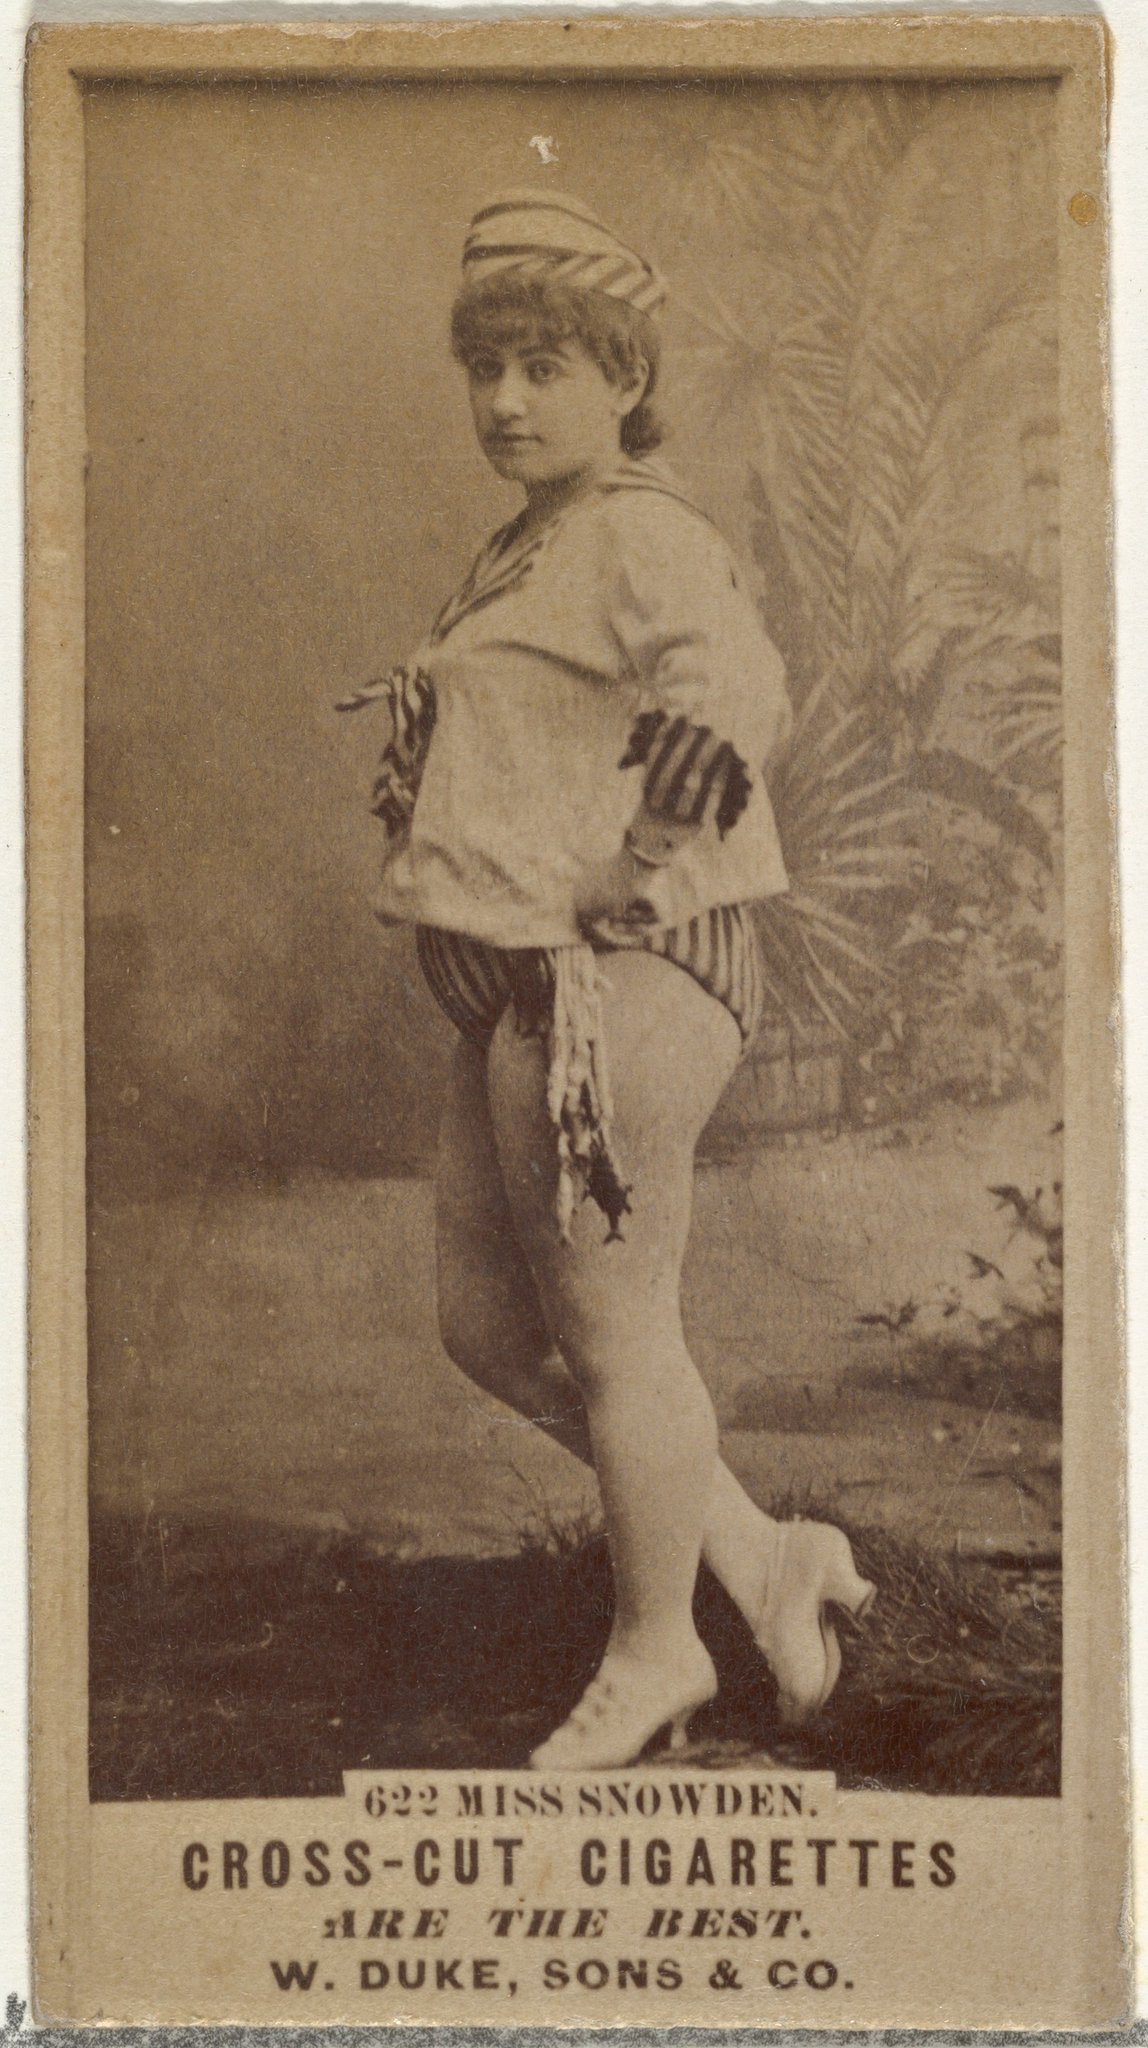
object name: photograph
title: Card Number 622, Miss Snowden, from the Actors and Actresses series (N145-3) issued by Duke Sons & Co. to promote Cross Cut Cigarettes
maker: w. duke, sons & co.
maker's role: publisher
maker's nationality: american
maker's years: 1870-1920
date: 1880-1889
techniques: albumen silver print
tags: portraits,women,actresses